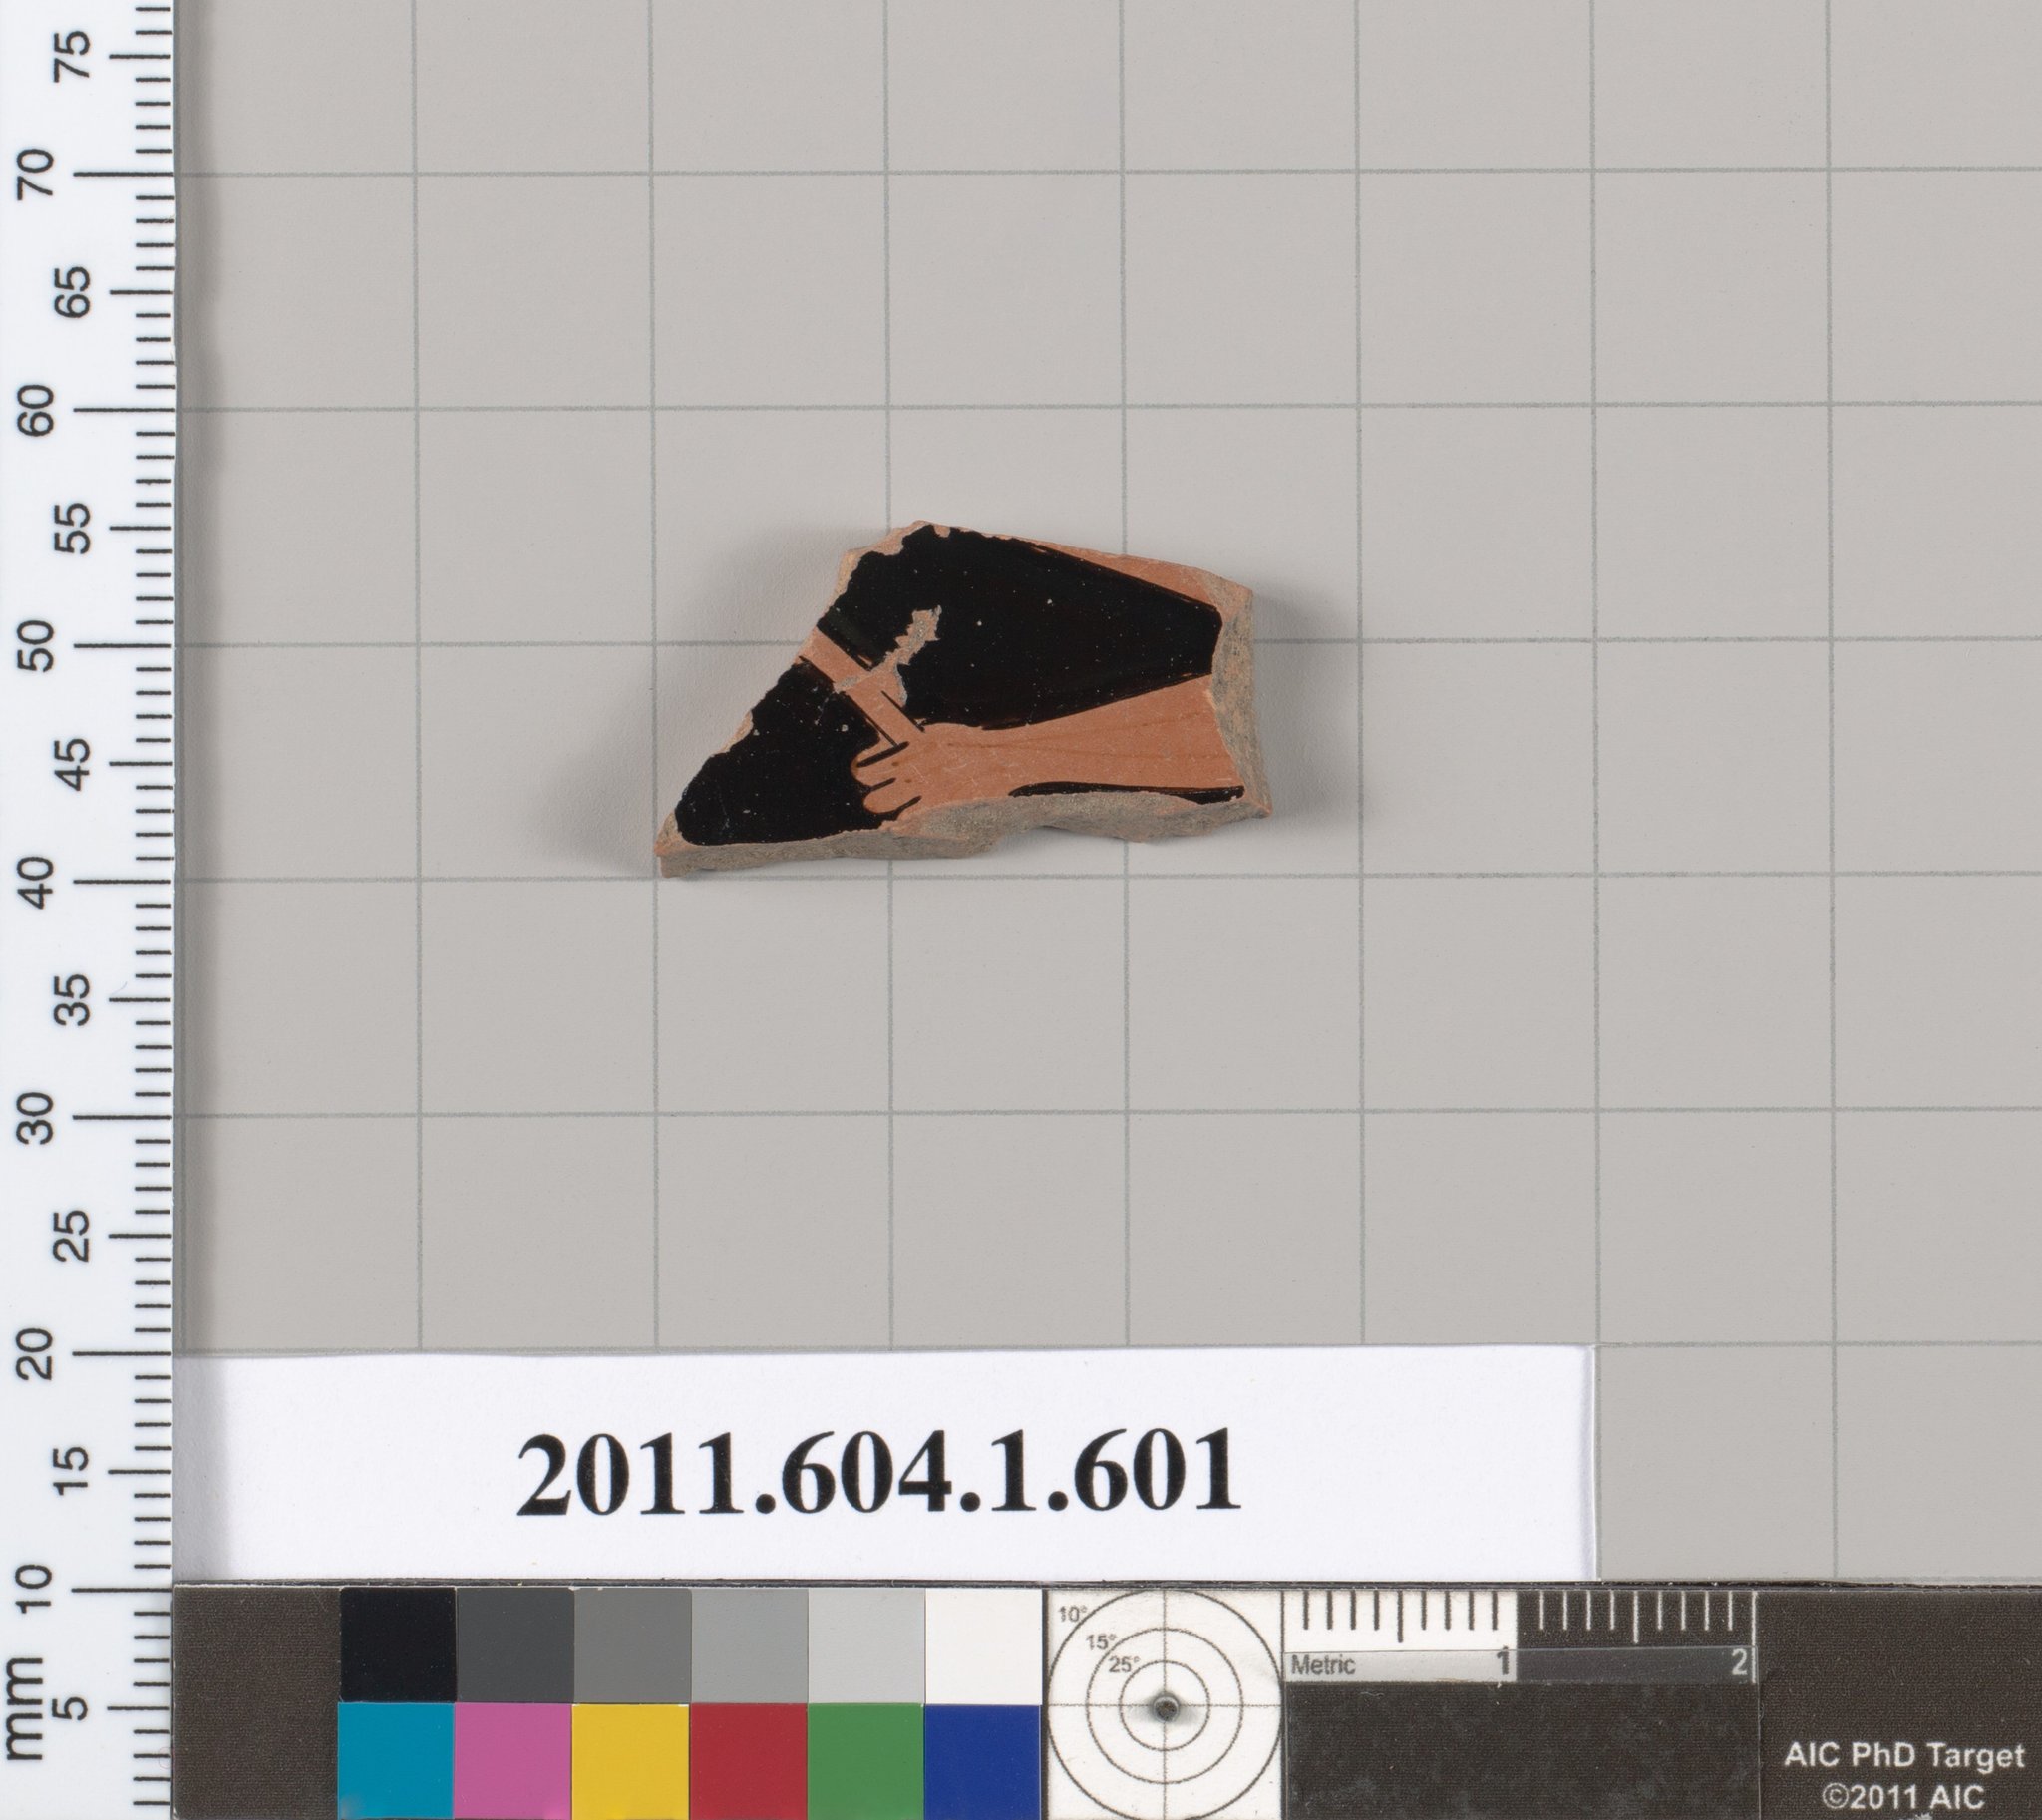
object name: kylix fragment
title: Terracotta fragment of a kylix (drinking cup)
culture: greek, attic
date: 475-451 BCE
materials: terracotta